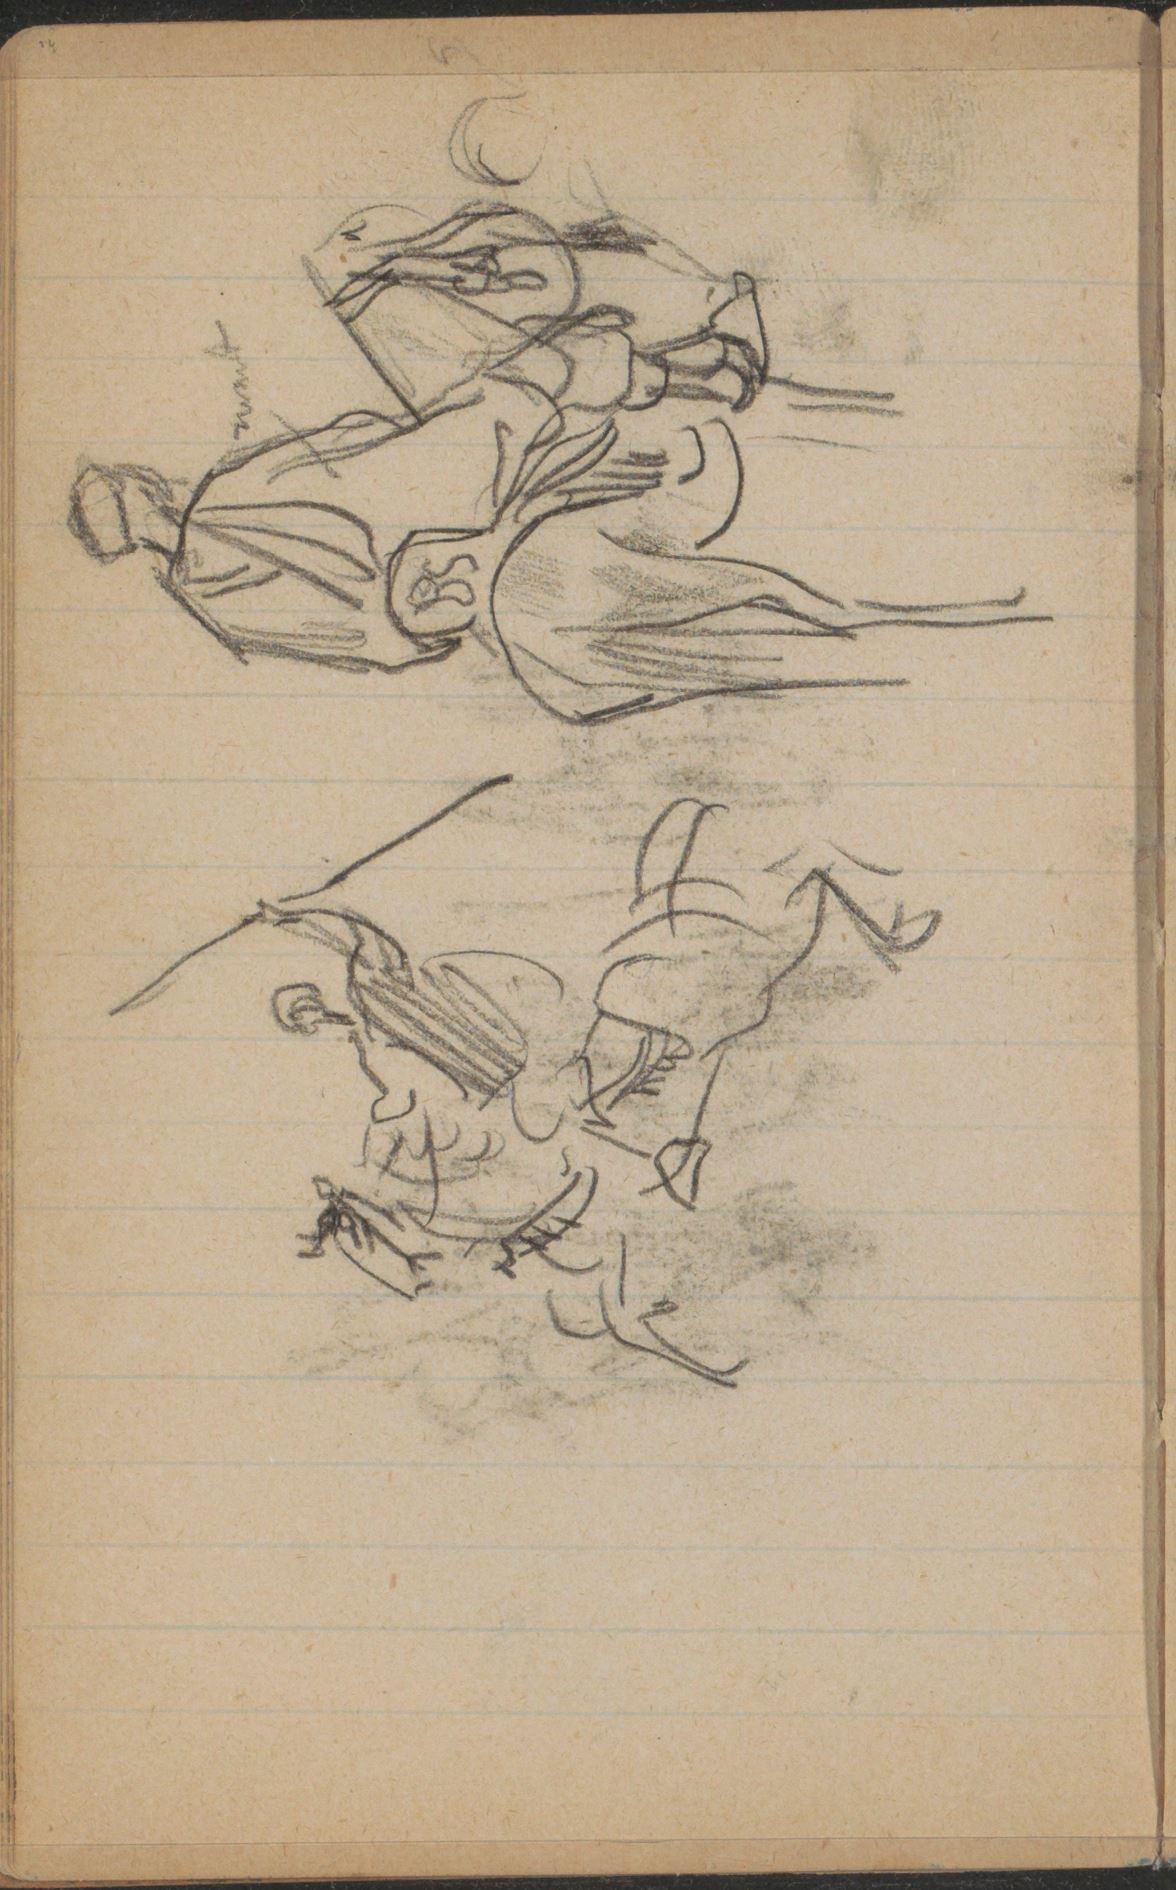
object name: sketchbook leaf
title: Ruiters met zwaarden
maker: marius bauer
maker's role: draughtsman, print maker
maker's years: 1867-1932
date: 1894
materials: chalk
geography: egypt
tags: riding a horse, ass, or mule; rider, horseman, africans, hacking and thrusting weapons: sword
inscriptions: kleurnotitie, handgeschreven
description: Pagina 14 uit een schetsboek met 48 bladen.